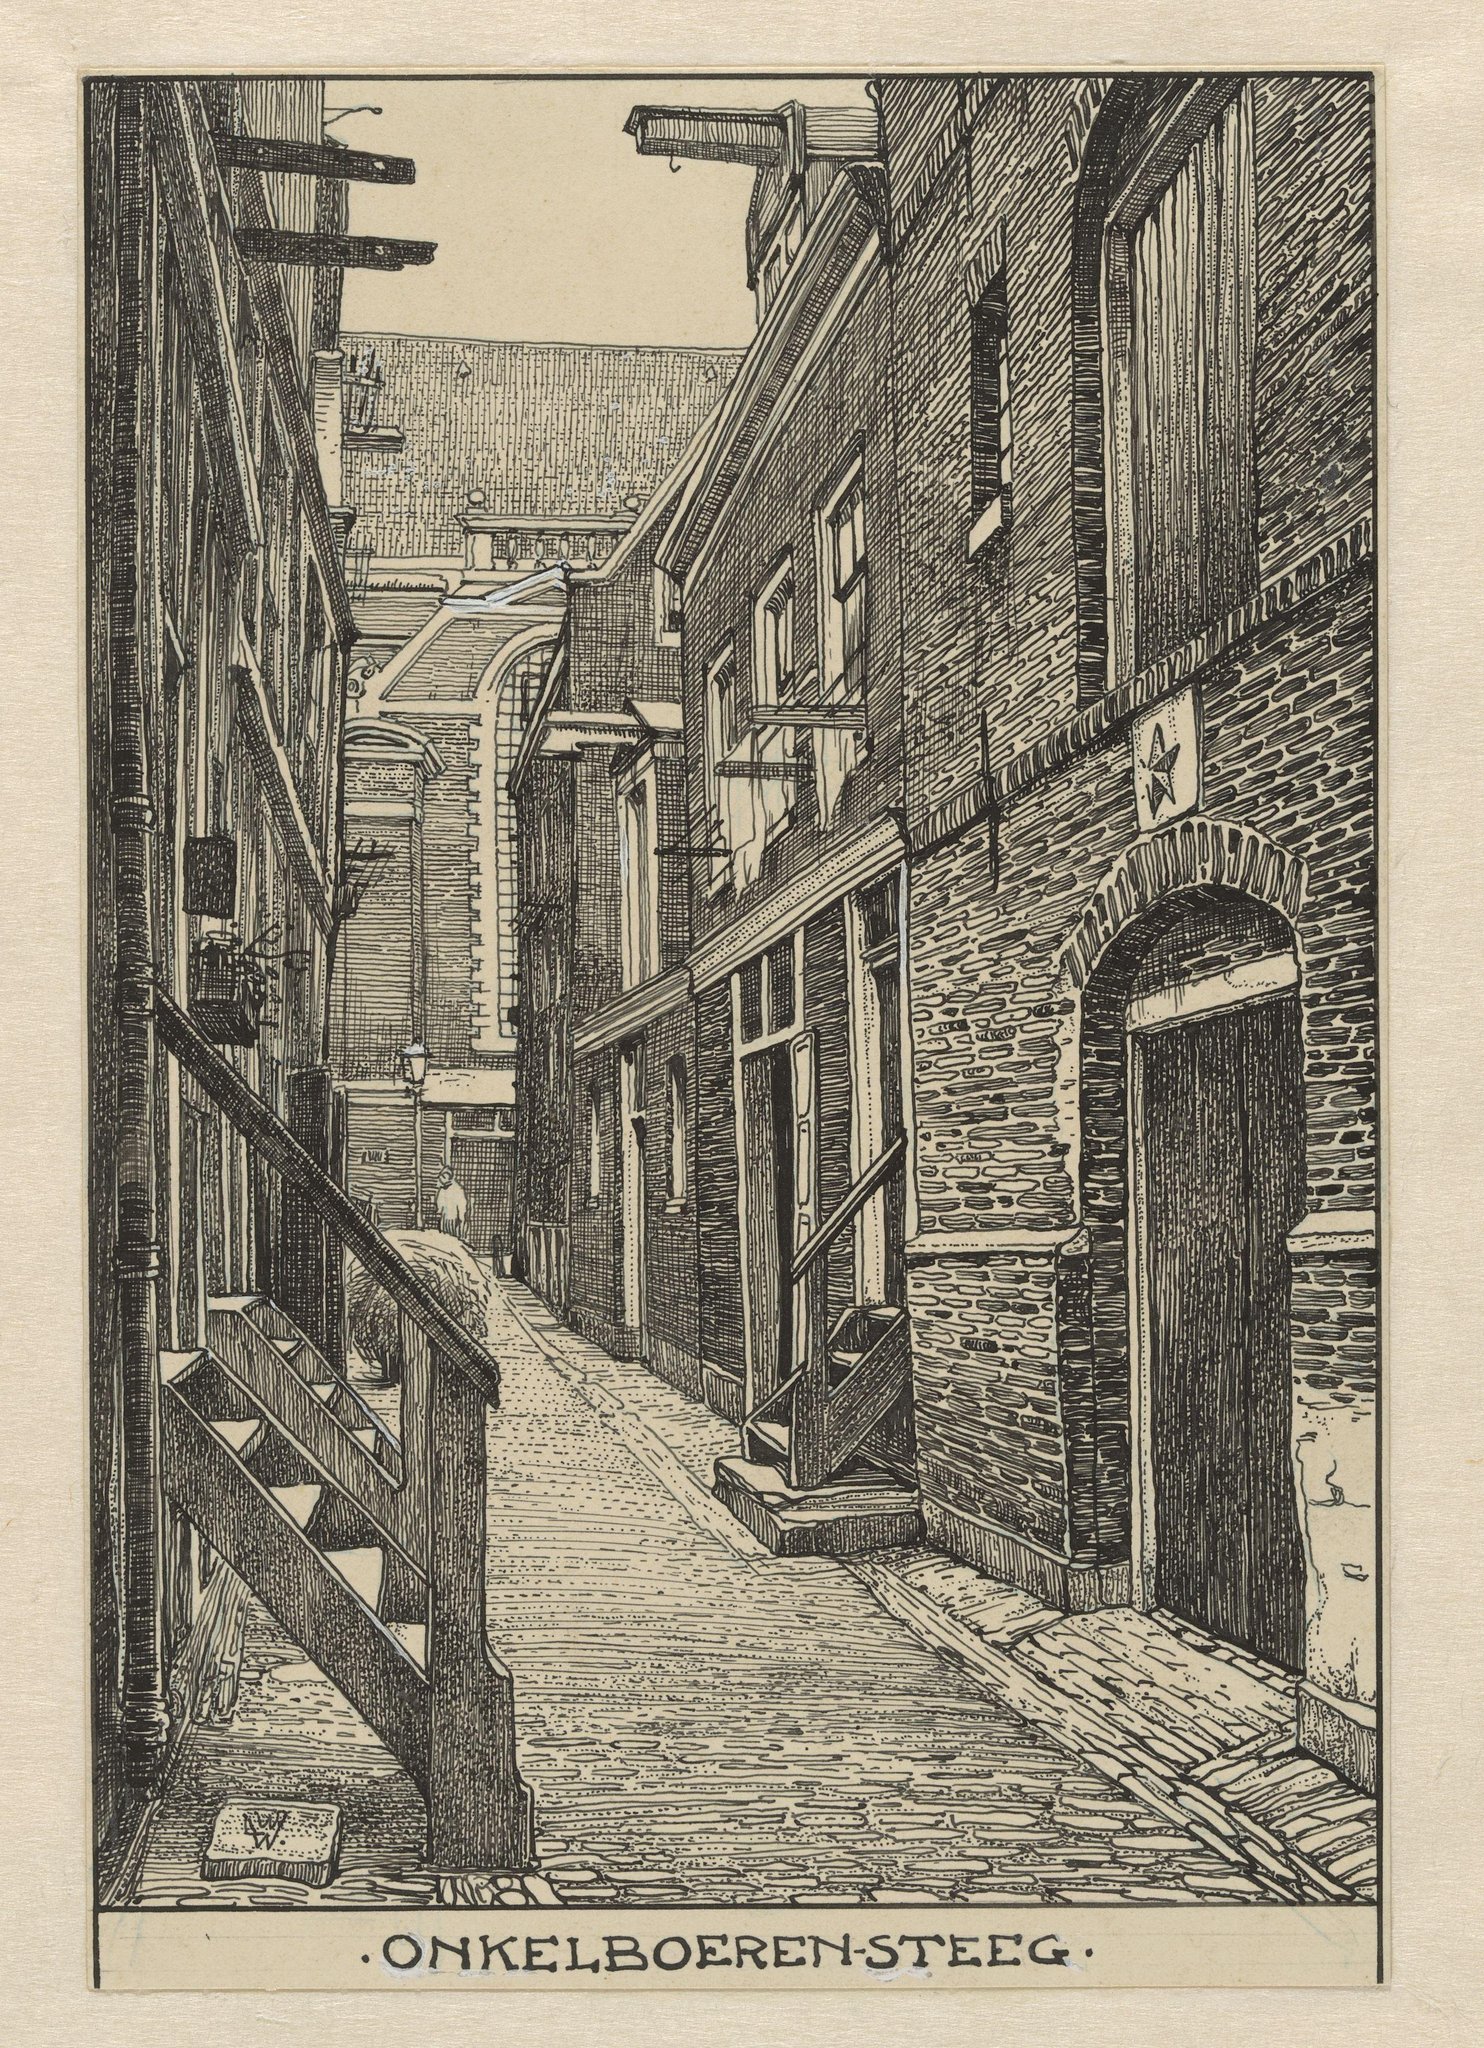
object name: drawing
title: De Onkel Boeren Steeg te Amsterdam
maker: willem wenckebach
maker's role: designer, draughtsman, painter, print maker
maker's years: 1860-1937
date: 1870-1926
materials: paint, ink, paper, pencil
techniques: pen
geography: amsterdam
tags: lane, alley